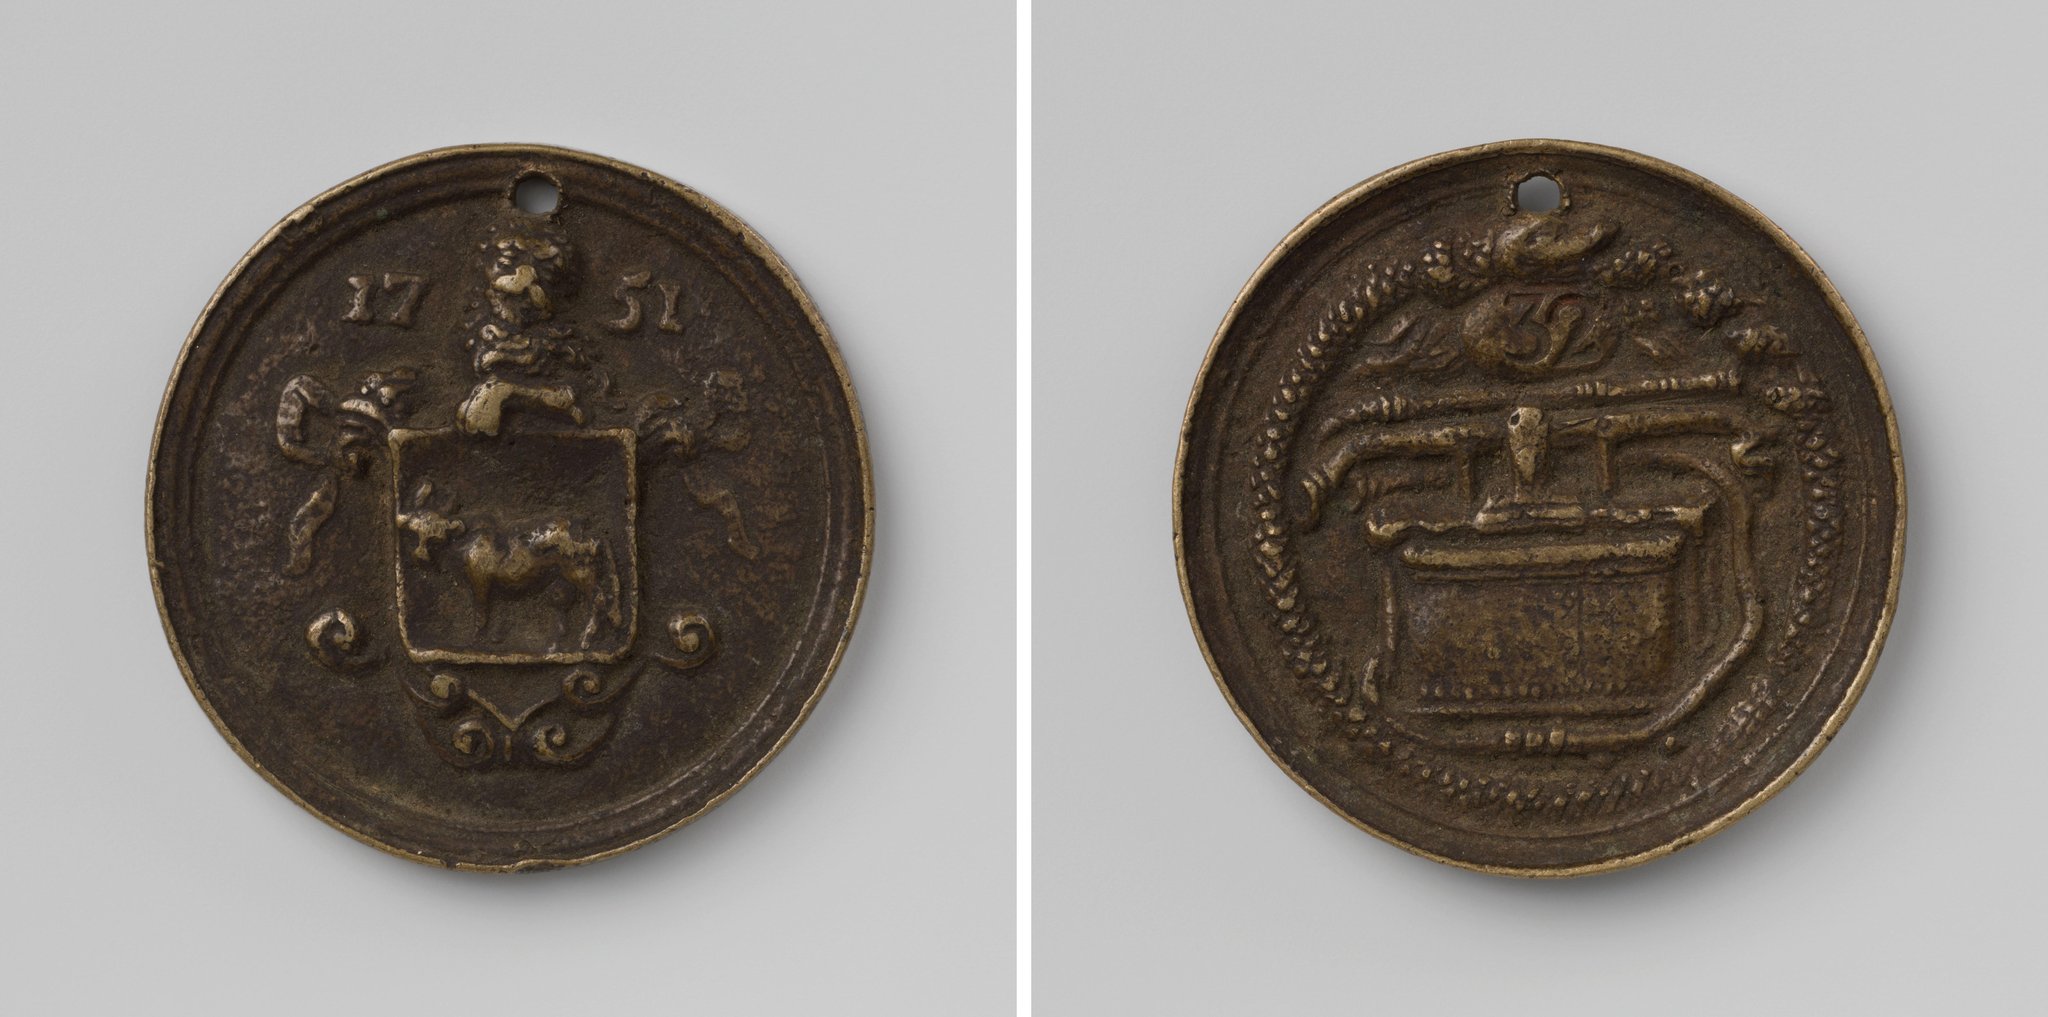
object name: fire engine medal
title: Beemster, brandspuitpenning met no. 32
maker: Anonymous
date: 1751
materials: brass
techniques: casting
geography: beemster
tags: beemster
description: Messing penning met gat erin. Voorzijde: wapenschild, gedragen door leeuw tussen jaartal. Keerzijde: brandspuit onder cartouche met cijfer 32 binnen slangerond